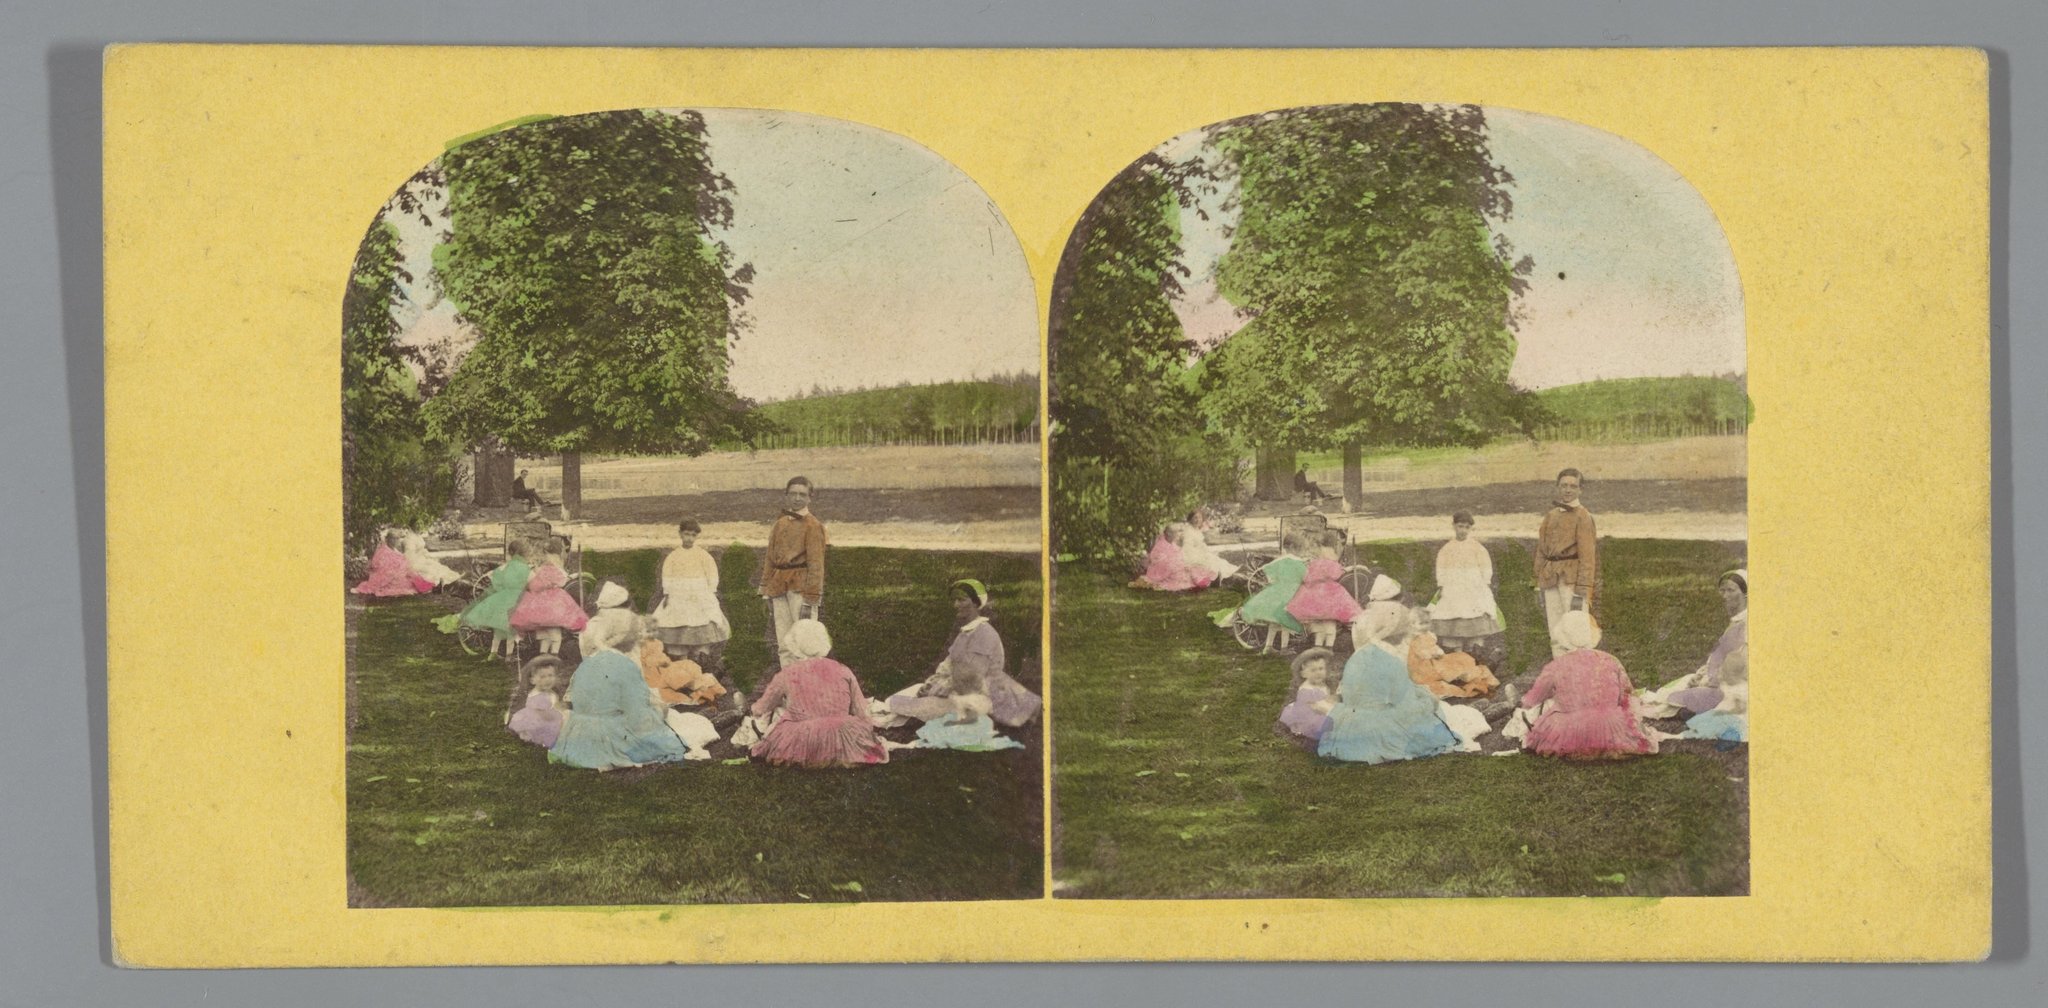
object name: stereograph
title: Groep mensen en kinderen op een veld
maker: Anonymous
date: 1858-1870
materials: cardboard, paper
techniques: albumen print, hand coloring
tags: park, open-air recreation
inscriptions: inscription: ‘F. 3’, inscription: ‘No. 2’, inscription: ‘P’, inscription: ‘JFP’